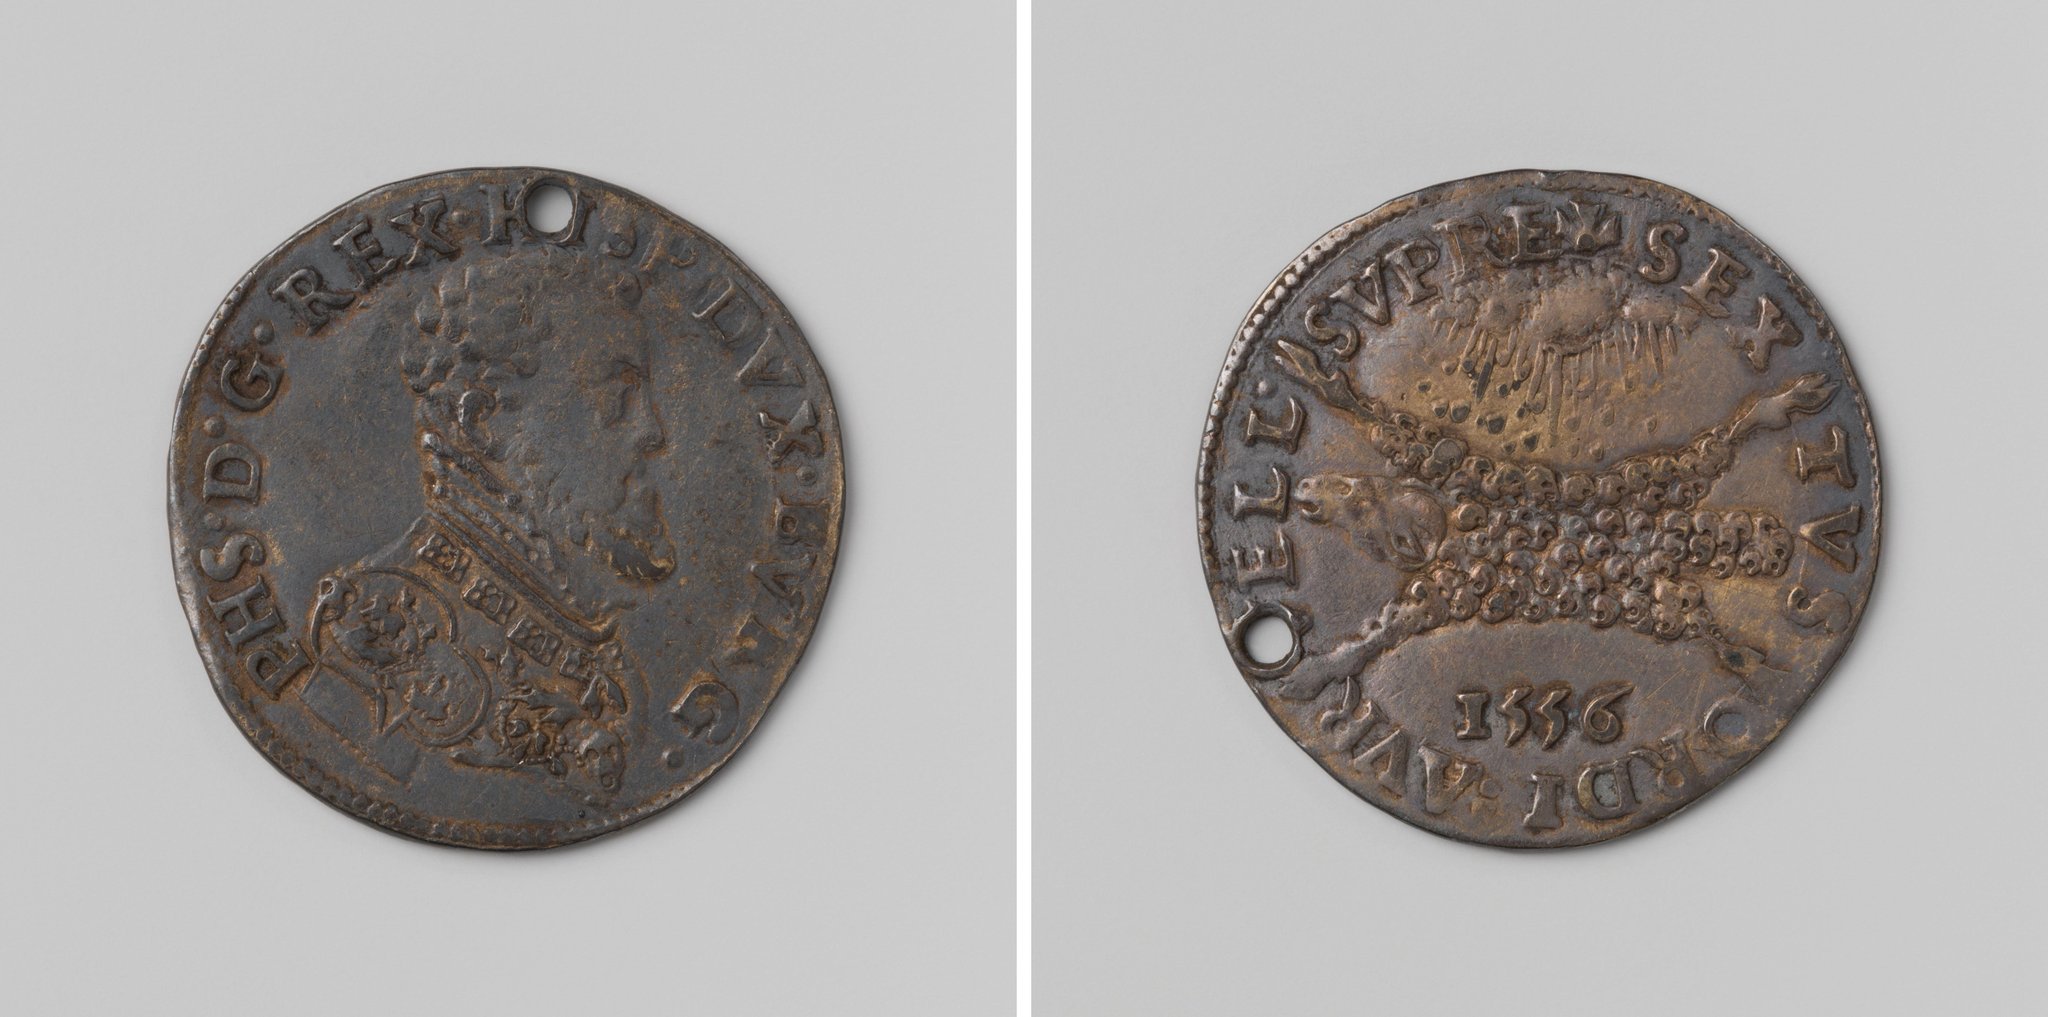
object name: jeton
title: Tweeentwintigste kapittel van de Orde van het Gulden Vlies te Antwerpen, ter ere van Filips II, koning van Spanje, souverein van de orde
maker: Anonymous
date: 1556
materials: silver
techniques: gilding, striking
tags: philip ii of spain, antwerp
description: Zilveren penning met gat erin. Voorzijde: borststuk man binnen omschrift. Keerzijde: Gulden Vlies, beschenen door hemellicht boven jaartal binnen omschrift